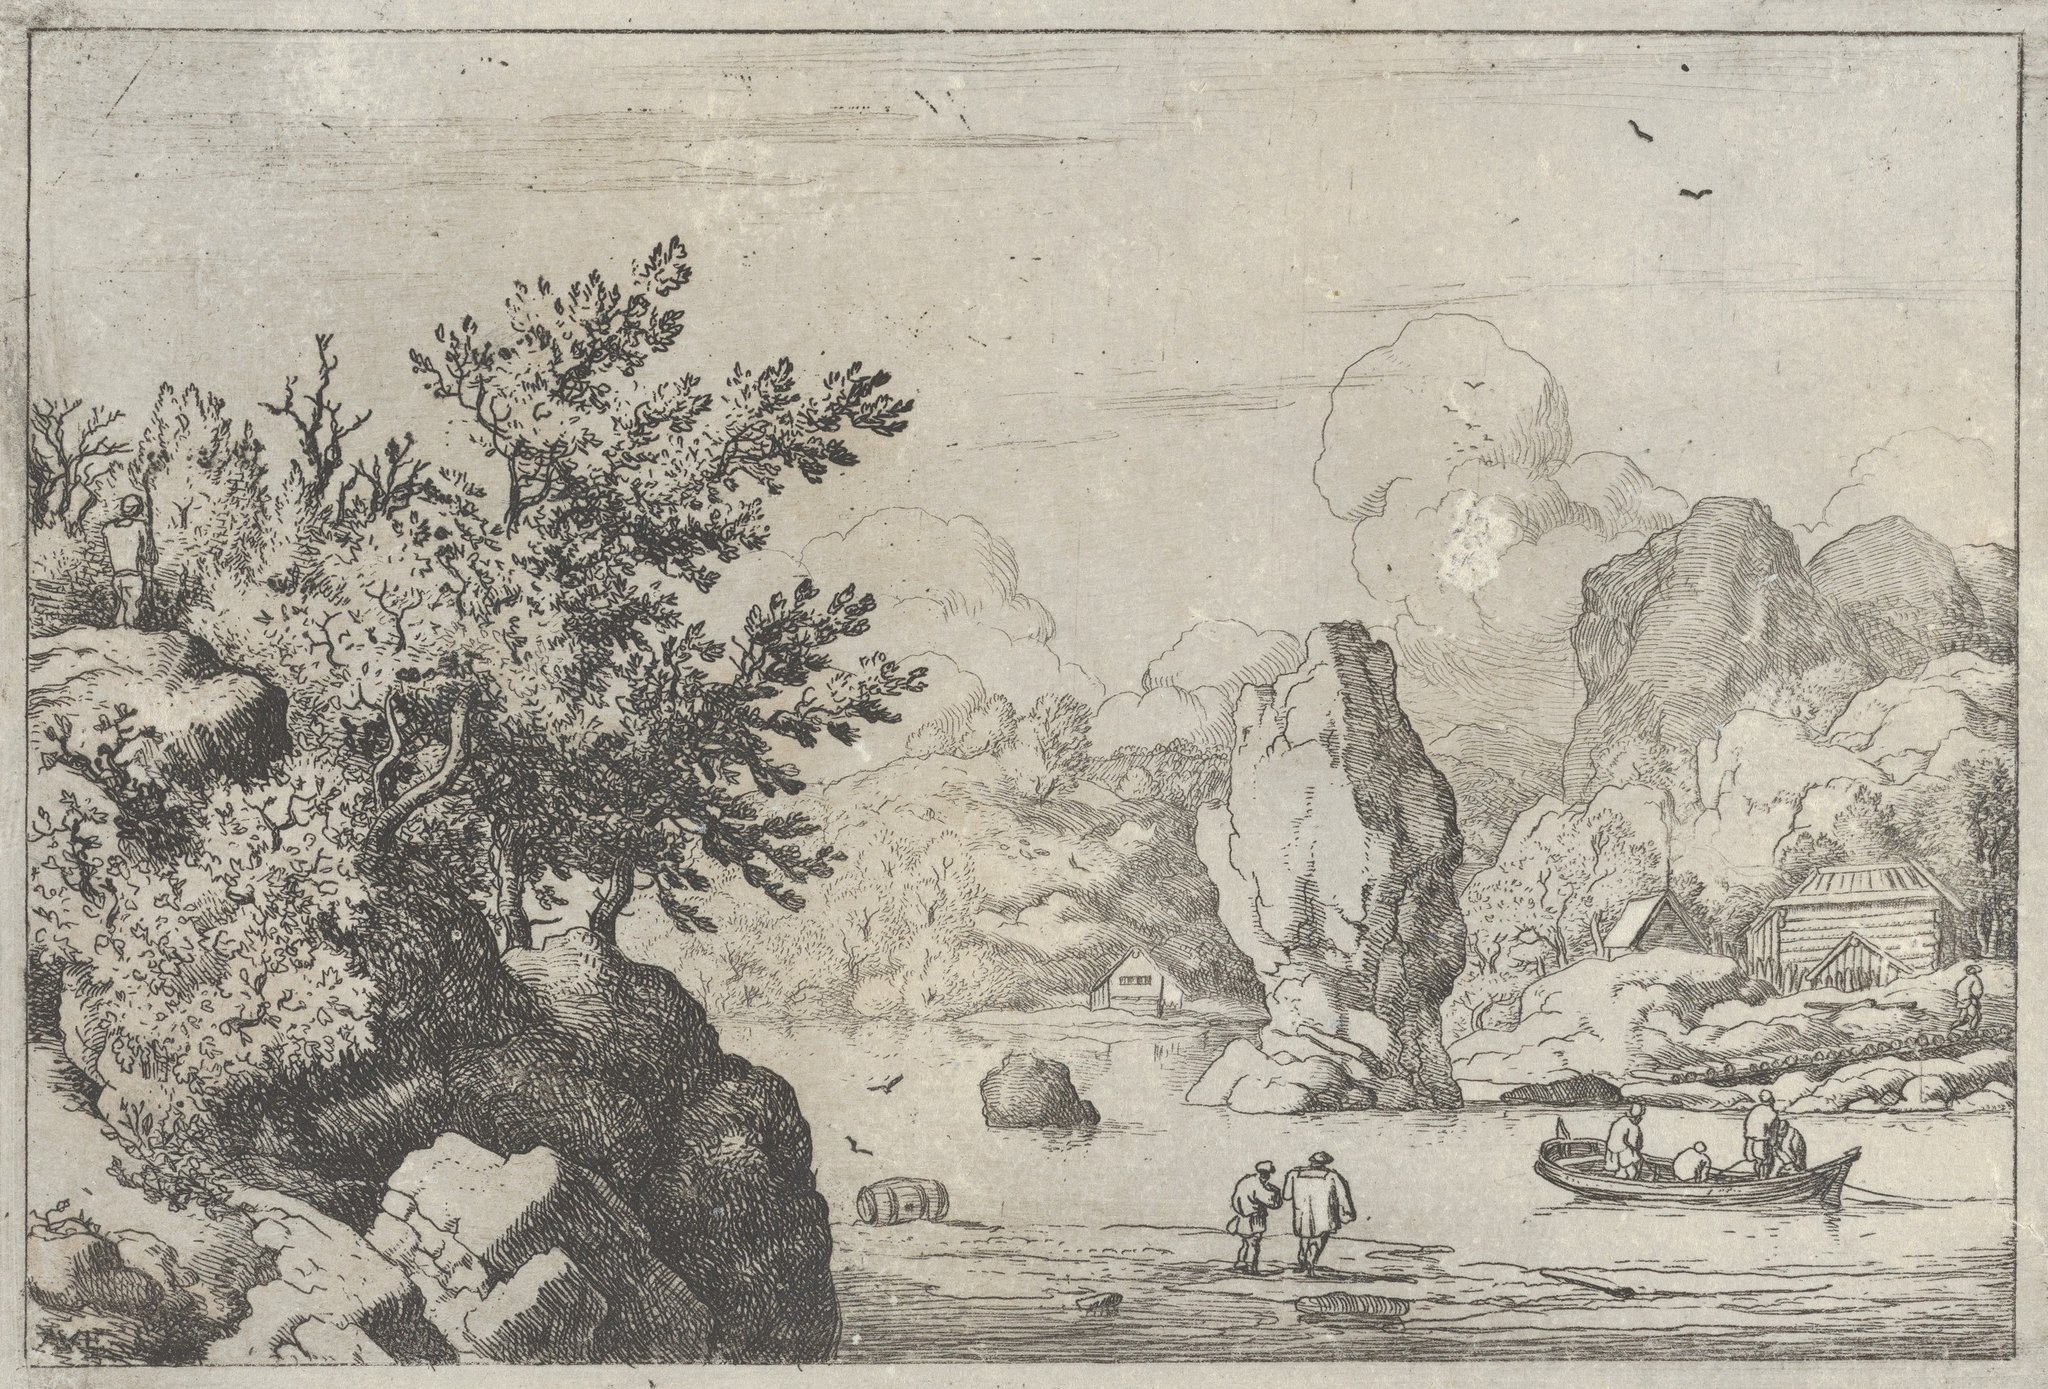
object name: print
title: The Rock in the Middle of the River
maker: allart van everdingen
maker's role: artist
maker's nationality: dutch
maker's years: 1621-1675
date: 1601-1700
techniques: engraving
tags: human figures,rivers,trees,boats